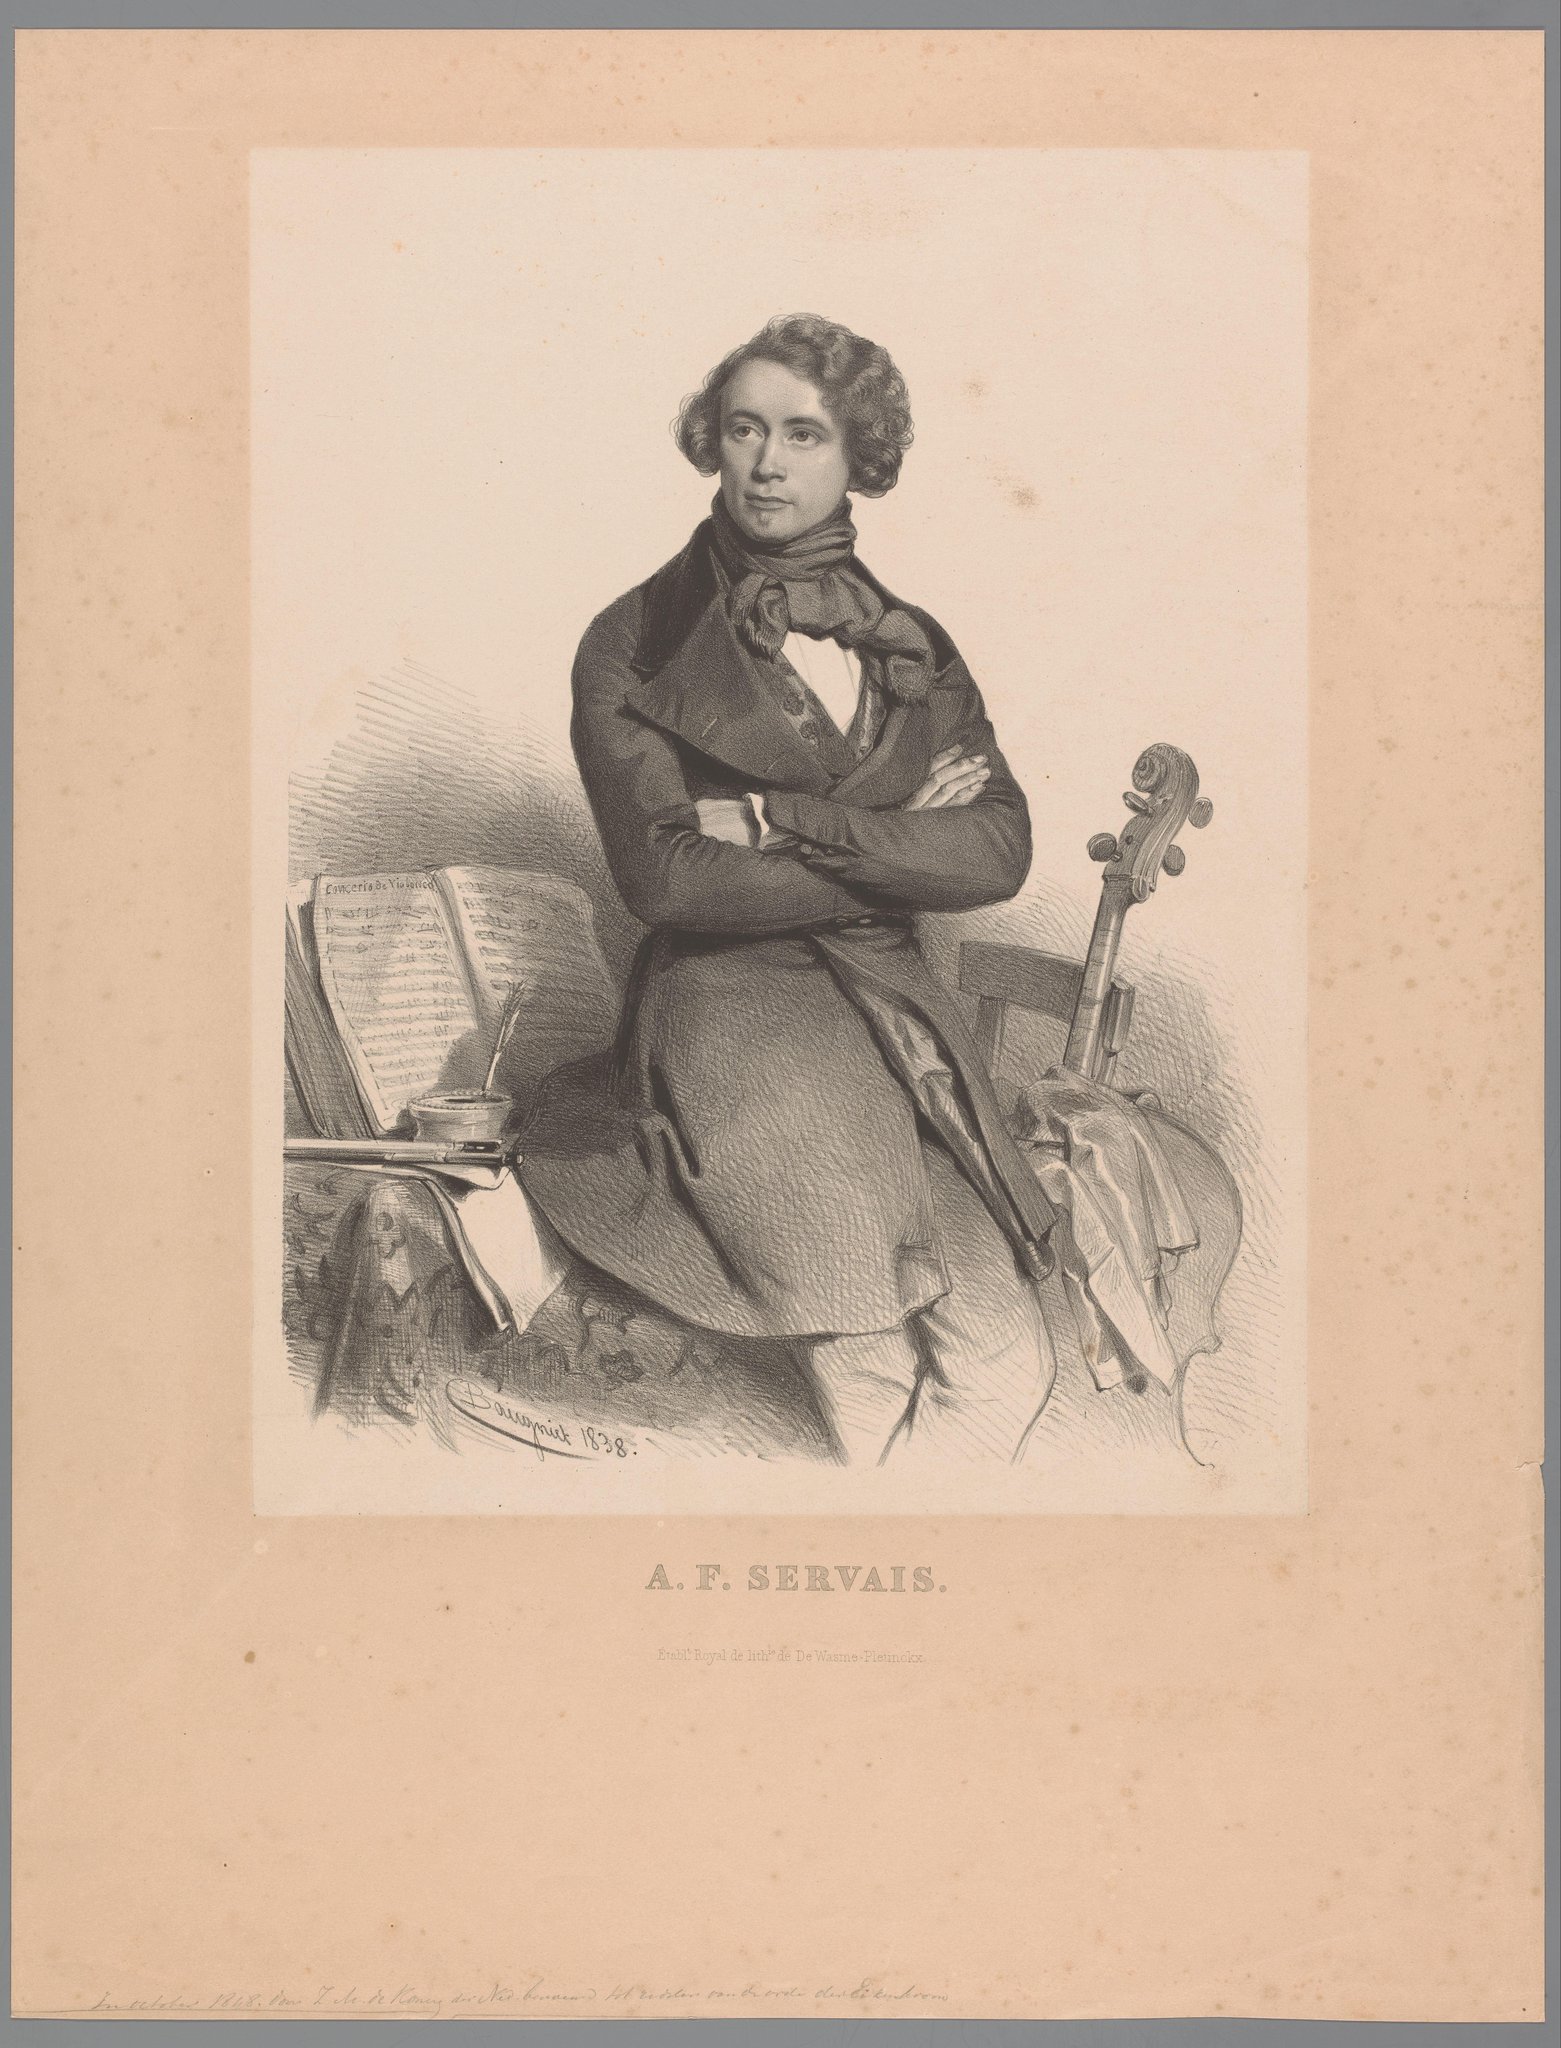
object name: print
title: Portret van Adrien-François Servais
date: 1838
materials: paper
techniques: lithograph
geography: brussels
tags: halle, notation of music, adult man, historical persons, viola, violoncello; double bass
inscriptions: collector's mark: Lugt 2228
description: Prent verschenen in: Baugniet, Charles. Les artistes contemporains: portraits lithographiés d'après nature, accompagnés de notices sur la vie et les ouvrages de chacun d'eux. Brussel: De Wasme-Pletinckx, [1836-1840].